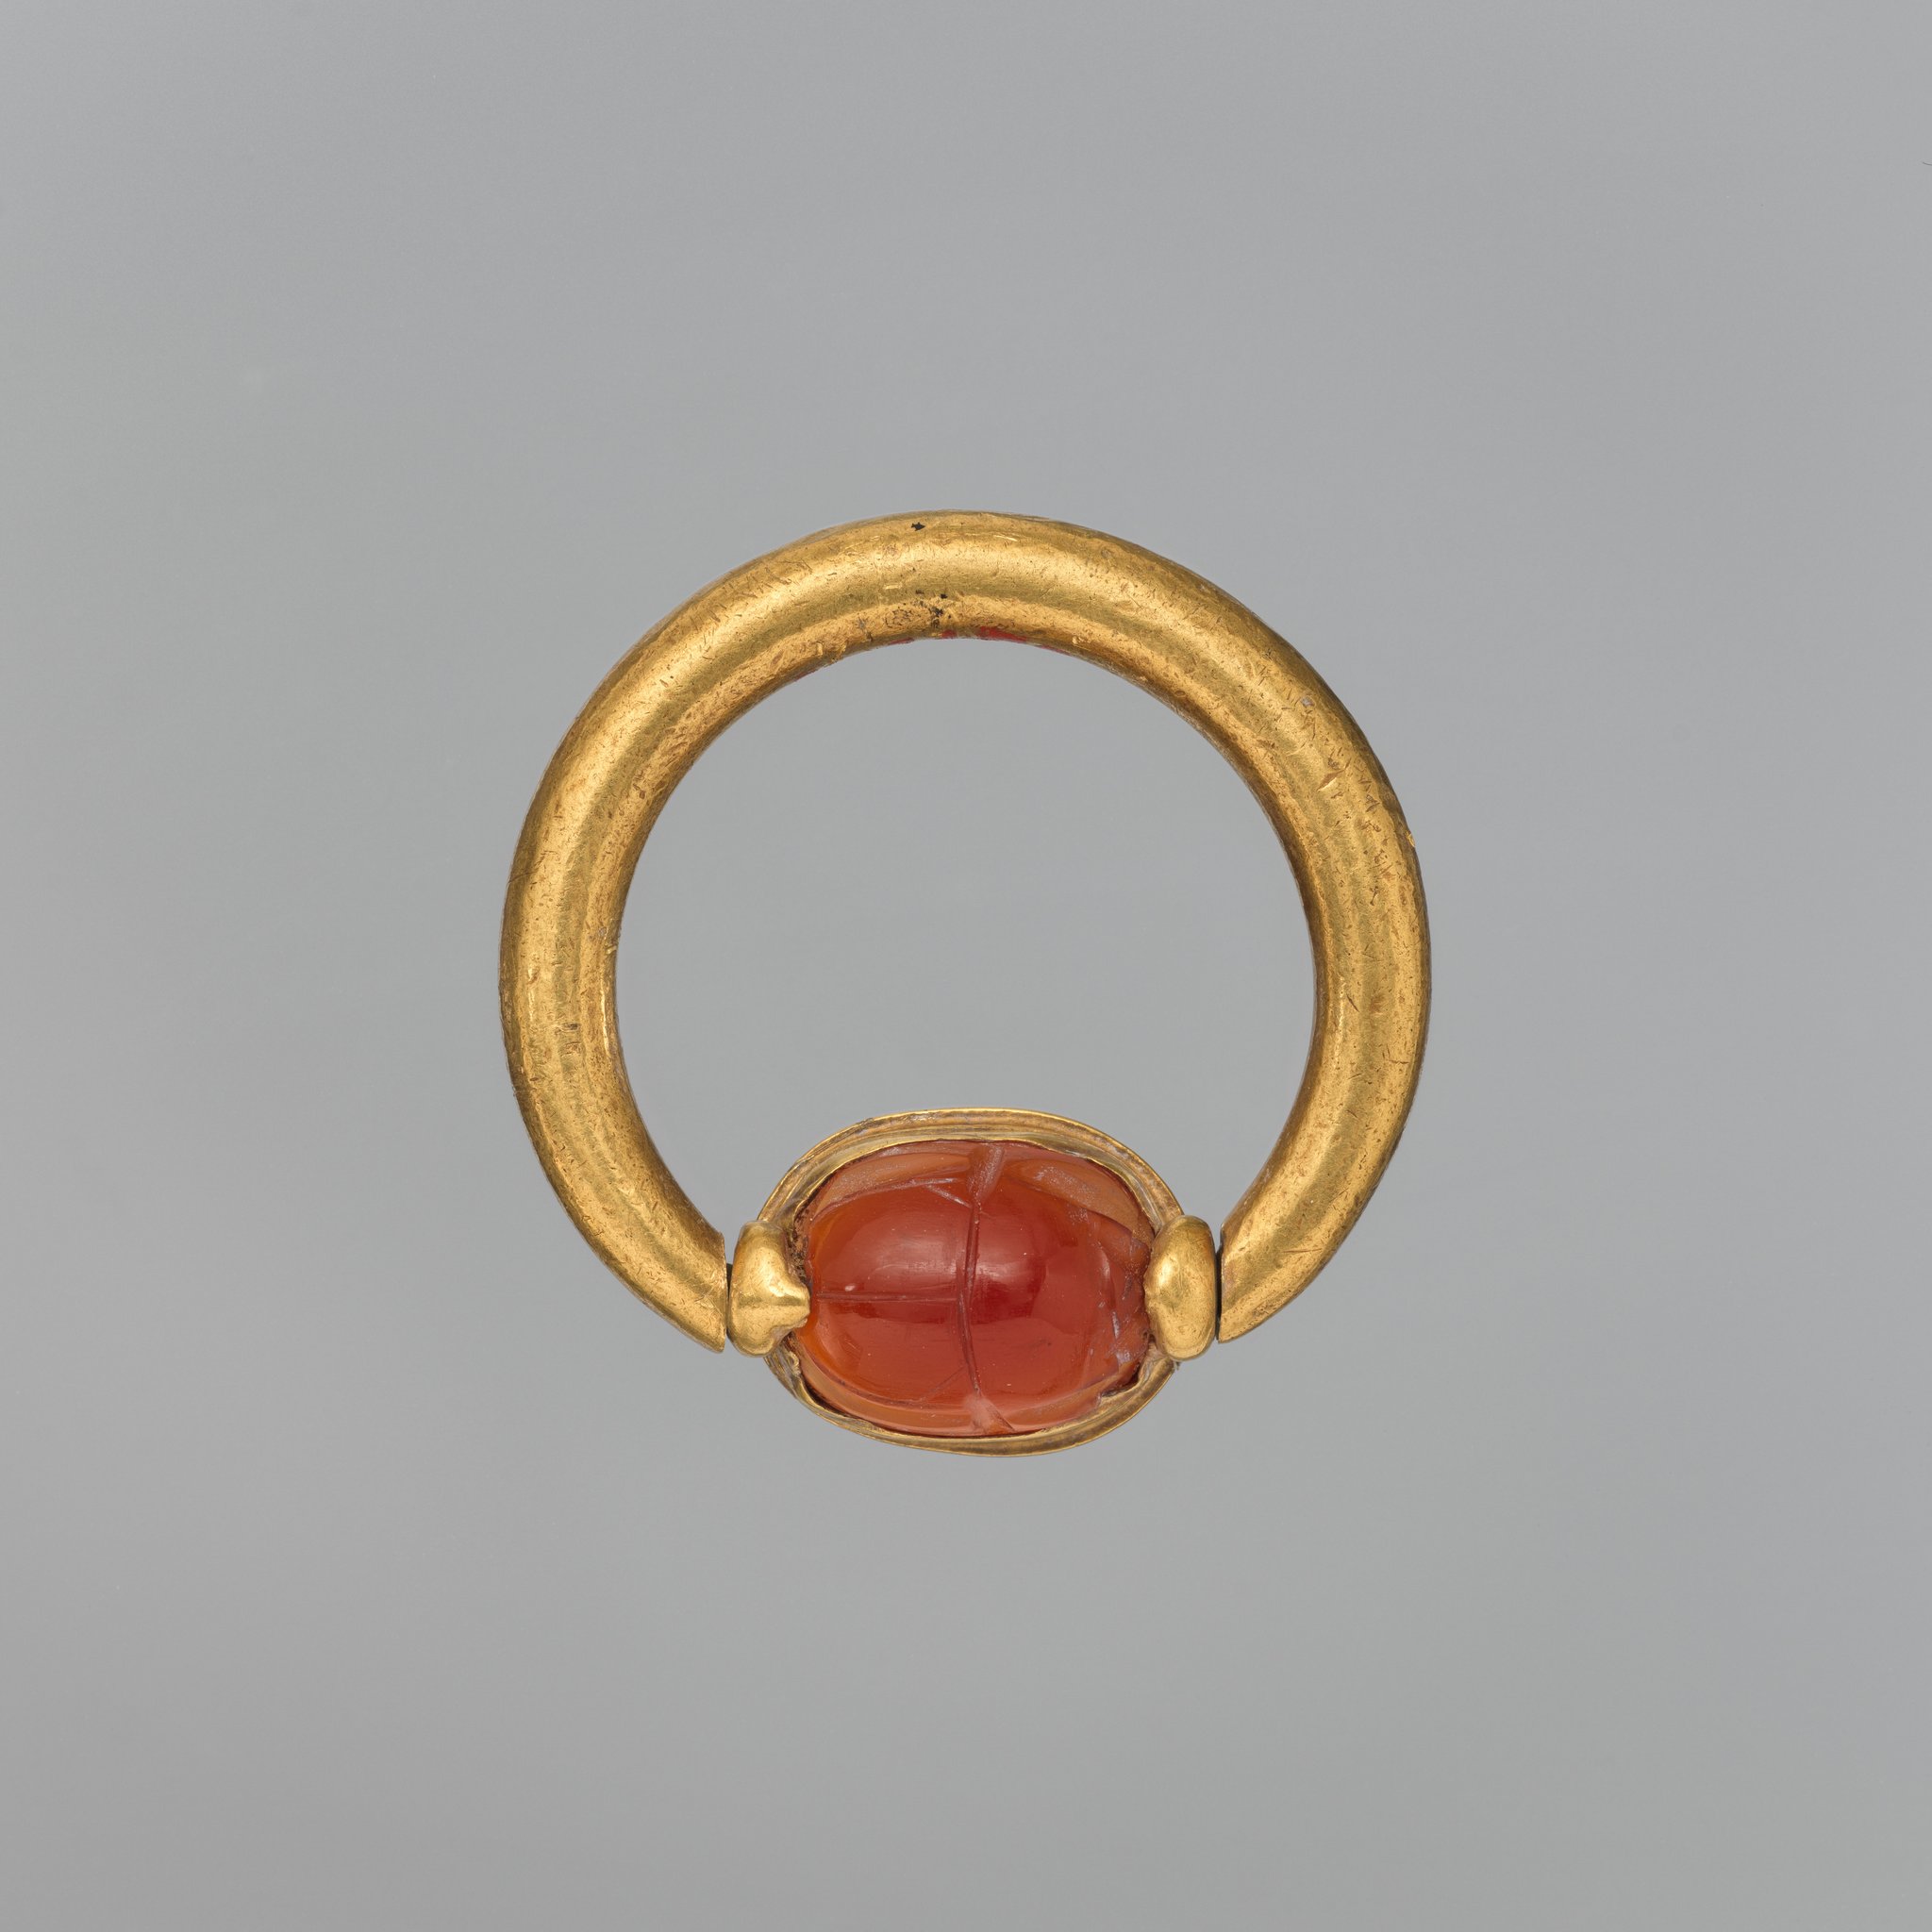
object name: ring with sard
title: Gold ring with carnelian scaraboid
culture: greek, cypriot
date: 500-401 BCE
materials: gemstone, gold